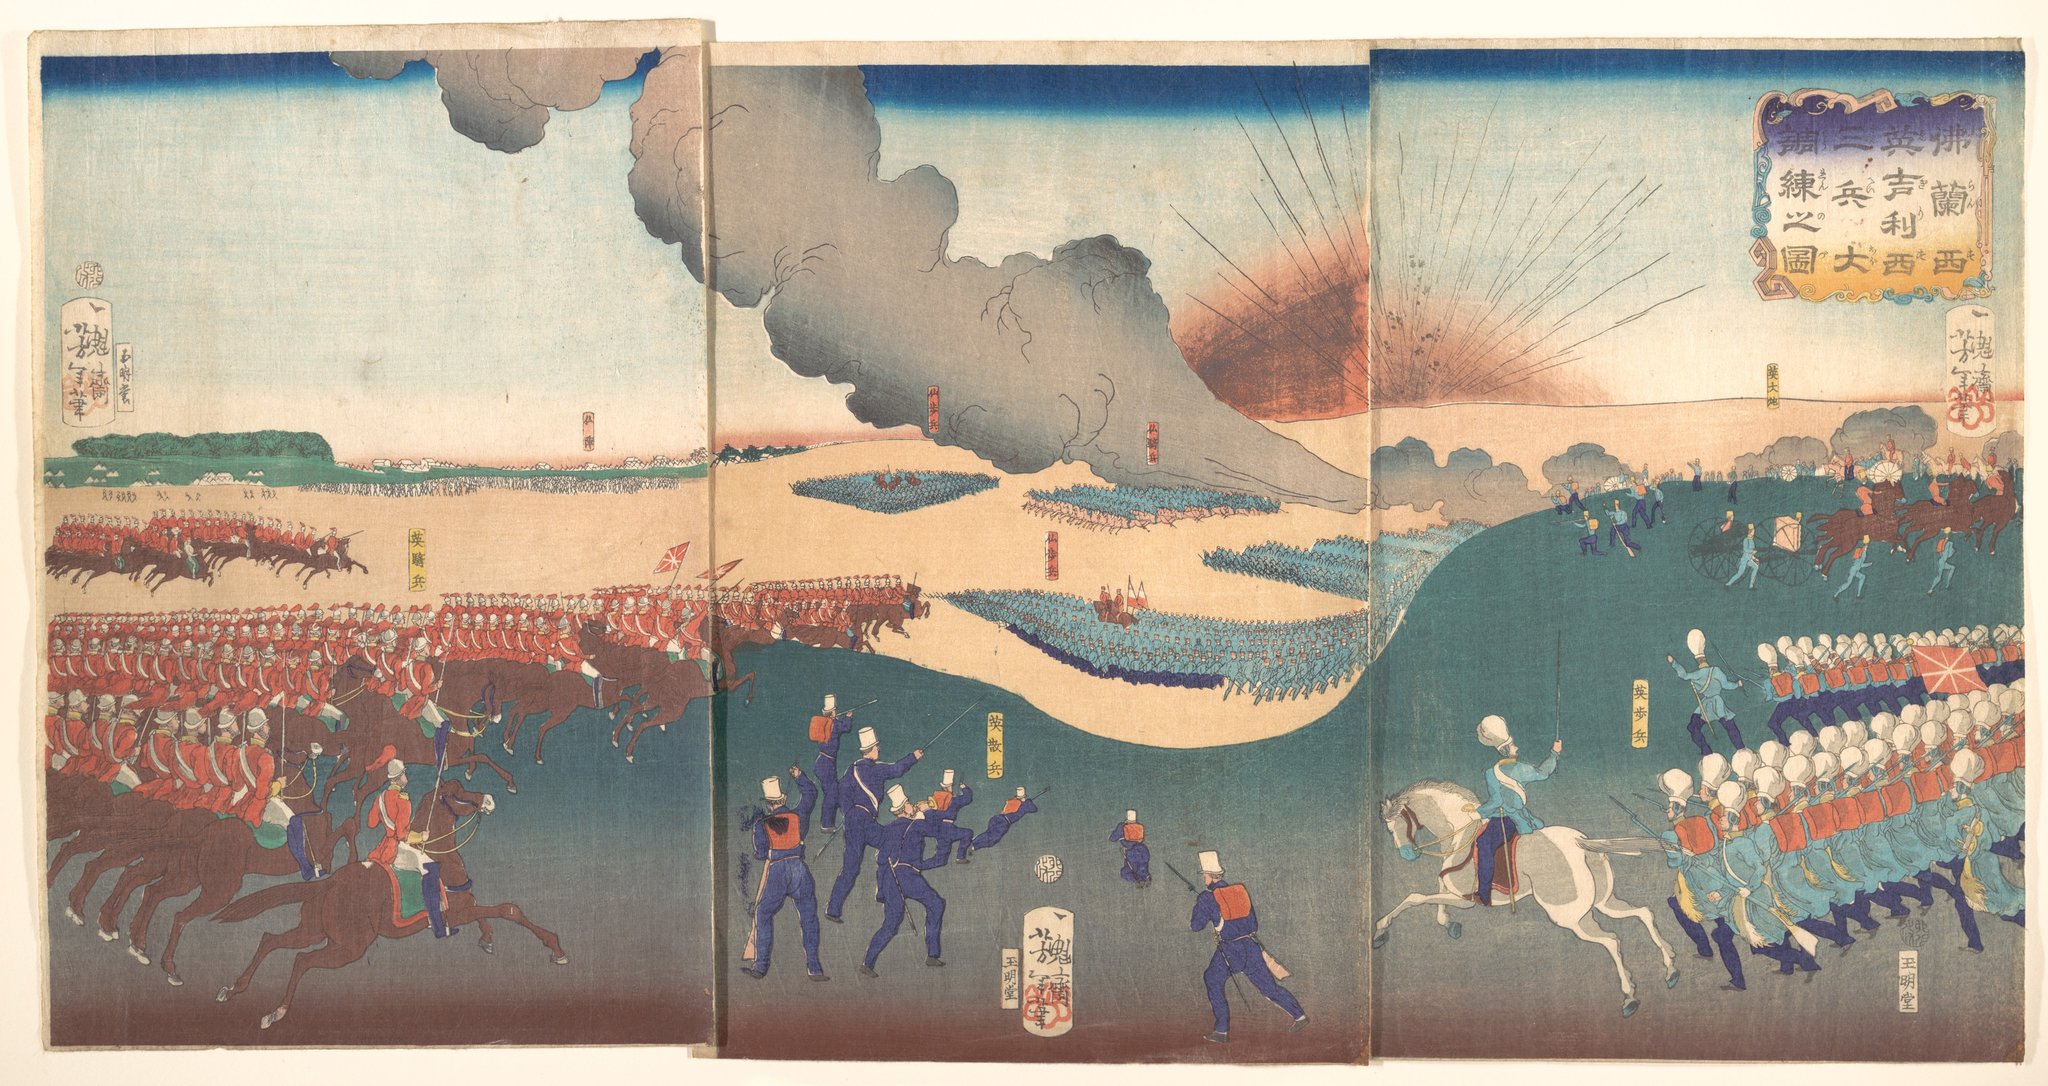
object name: print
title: Maneuvers by Three Categories of French and English Soldiers (Furansu Igirisu sanhei ōchōren no zu)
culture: japanese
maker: tsukioka yoshitoshi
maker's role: artist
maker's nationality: japanese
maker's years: 1839-1892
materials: ink, paper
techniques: woodblock print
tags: battles,soldiers,horses